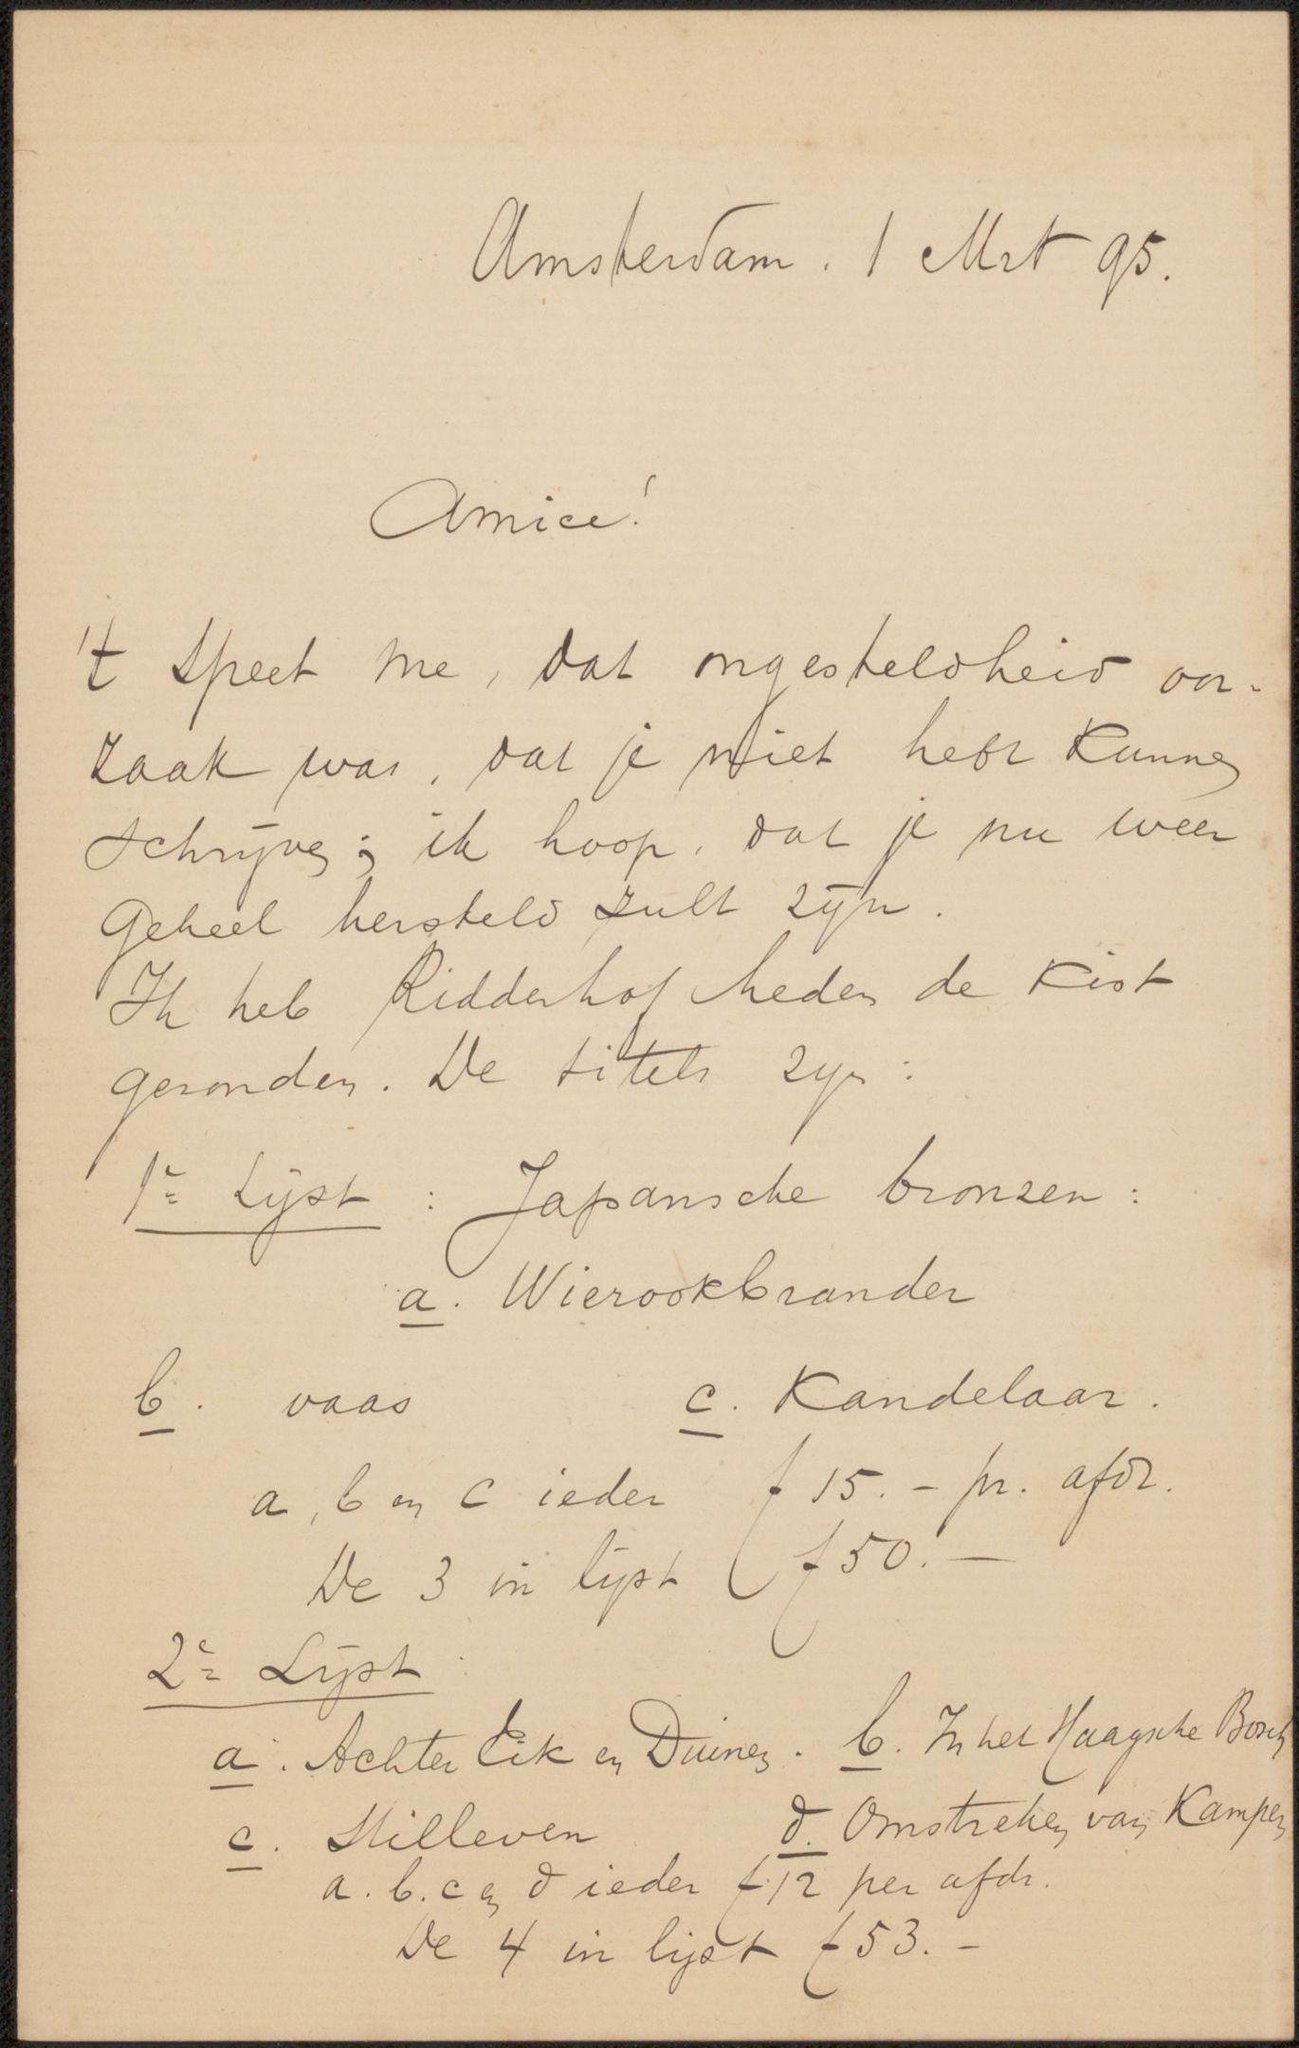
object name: letter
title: Brief aan Philip Zilcken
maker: albrecht felix reicher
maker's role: print maker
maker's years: 1858-1938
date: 1895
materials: ink, paper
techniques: pen, writing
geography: amsterdam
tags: painter, the hague, philip zilcken, the graphic arts, diseases, money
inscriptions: collector's mark: ‘RPK’